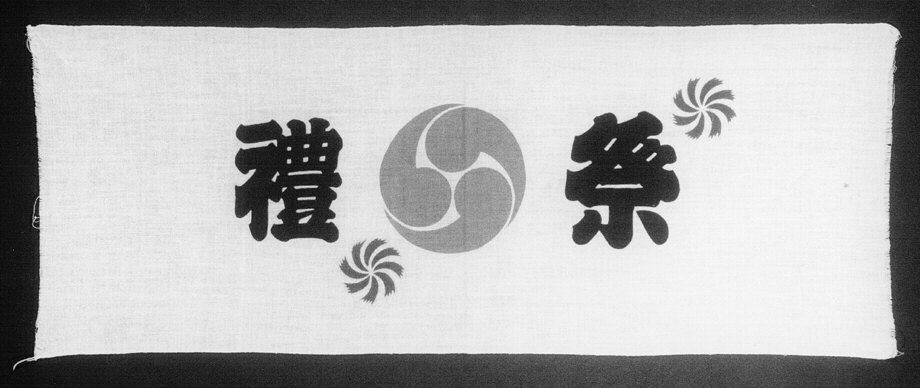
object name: strip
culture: japanese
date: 1901-1950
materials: cotton